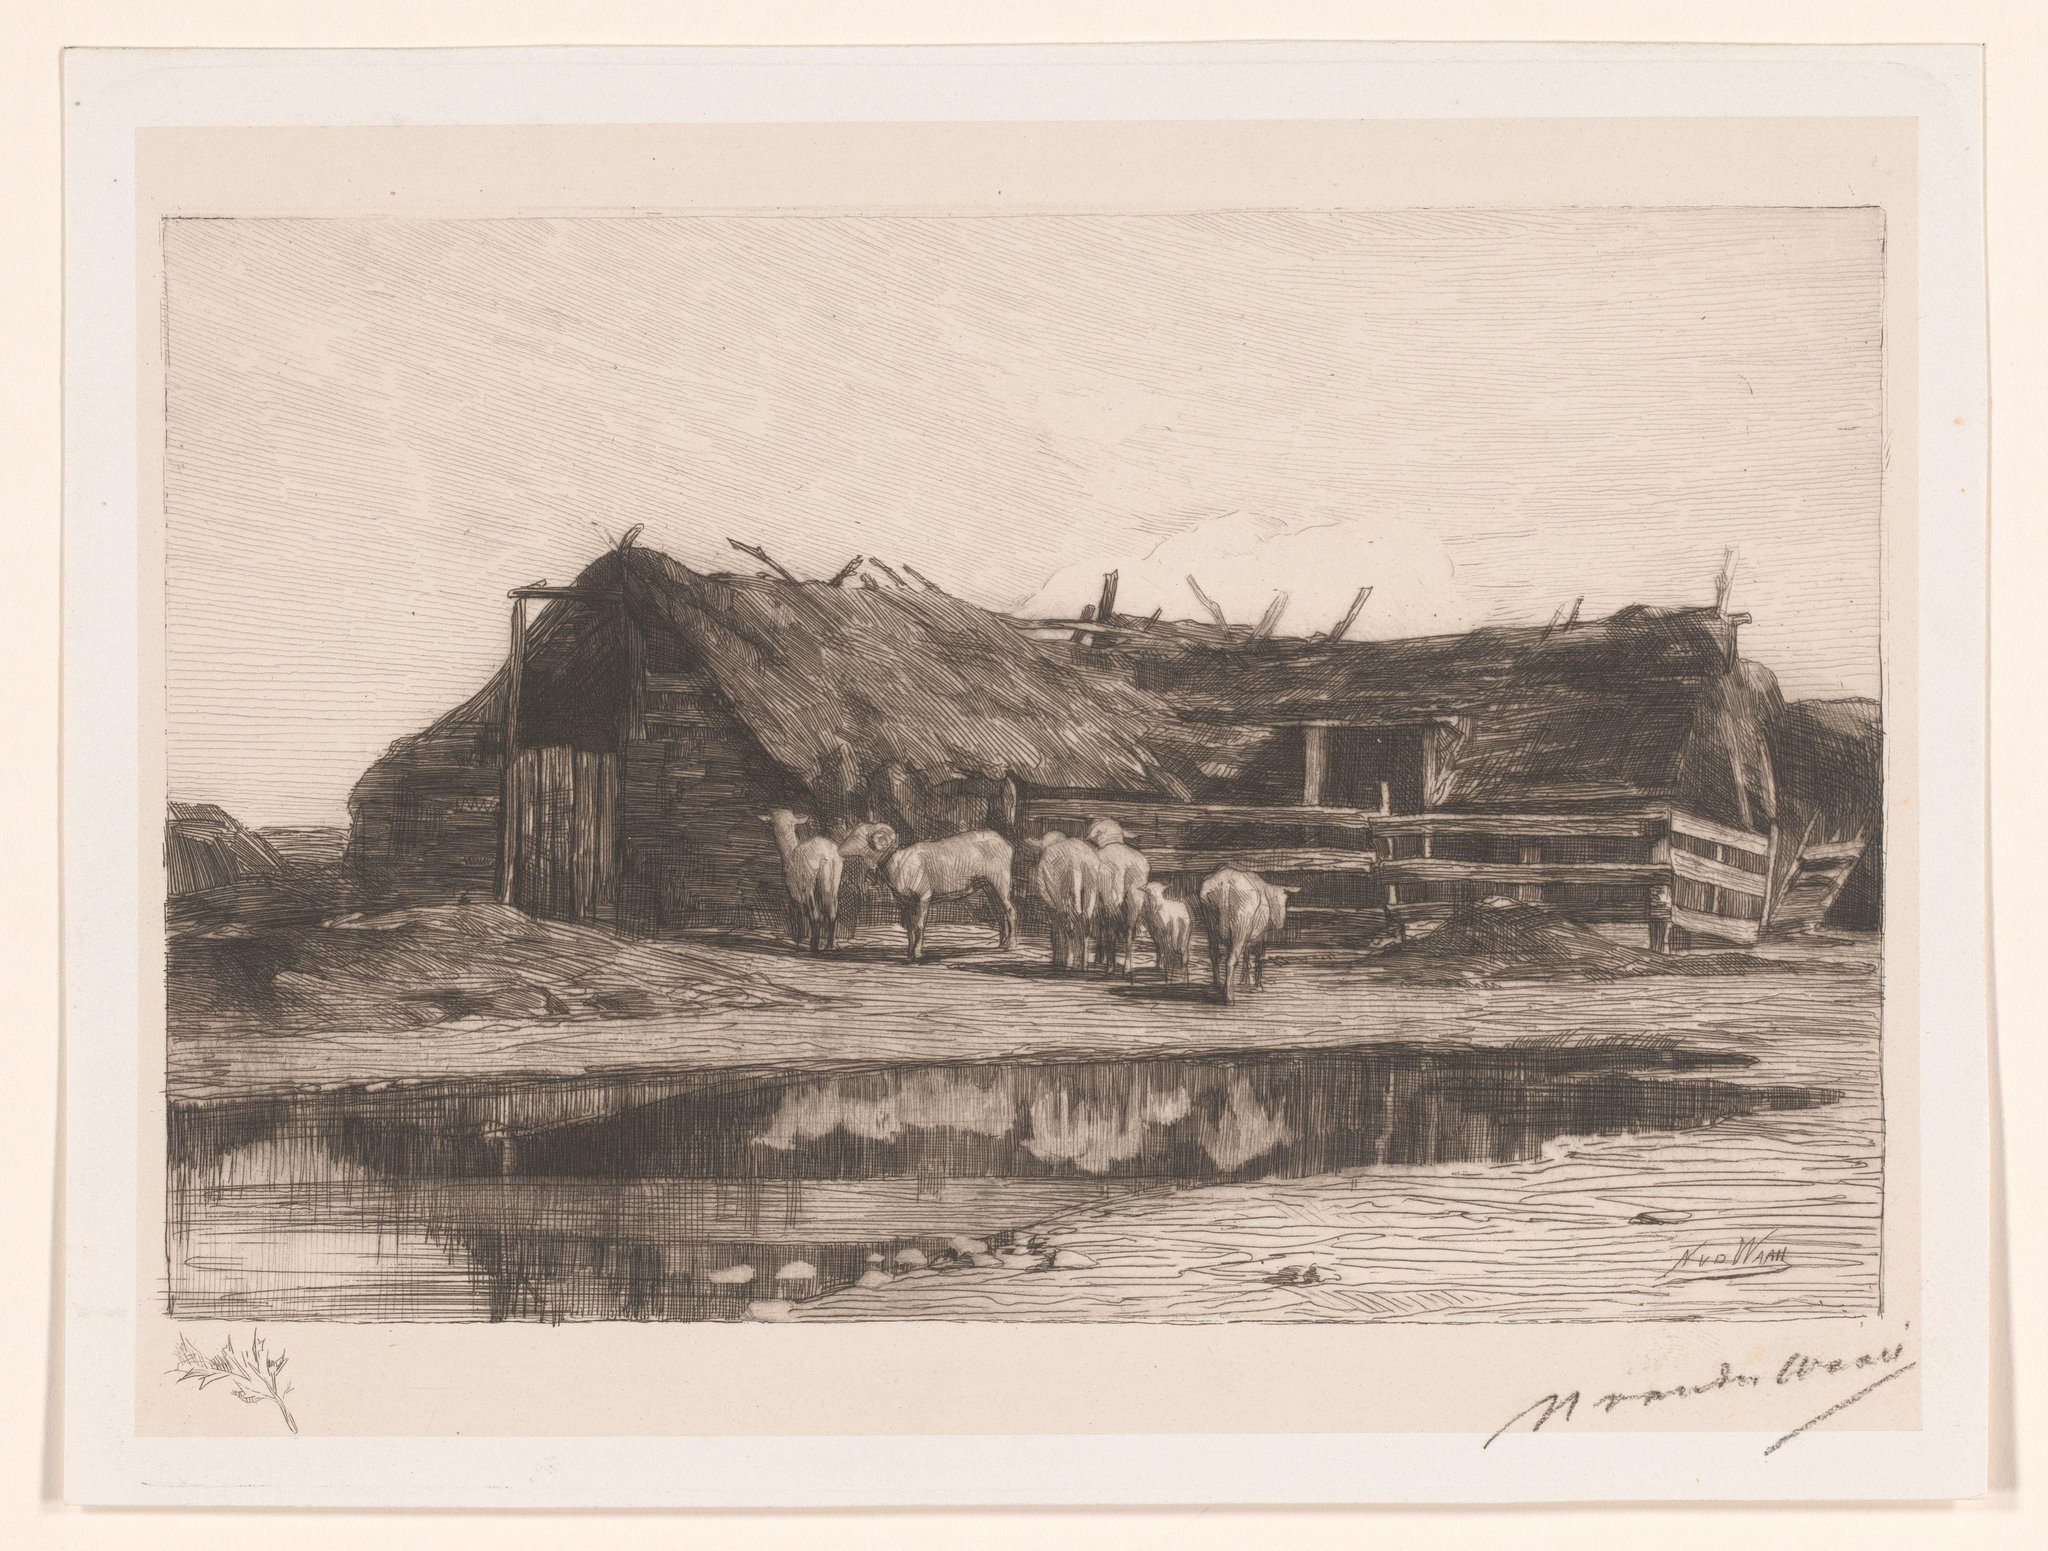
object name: print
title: Drentse schaapskooi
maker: nicolaas van der waay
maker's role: draughtsman, painter, print maker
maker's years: 1855-1936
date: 1865-1936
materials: paper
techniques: drypoint, etching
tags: piglet, suckling pig, stall, stable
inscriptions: collector's mark: Lugt 2228